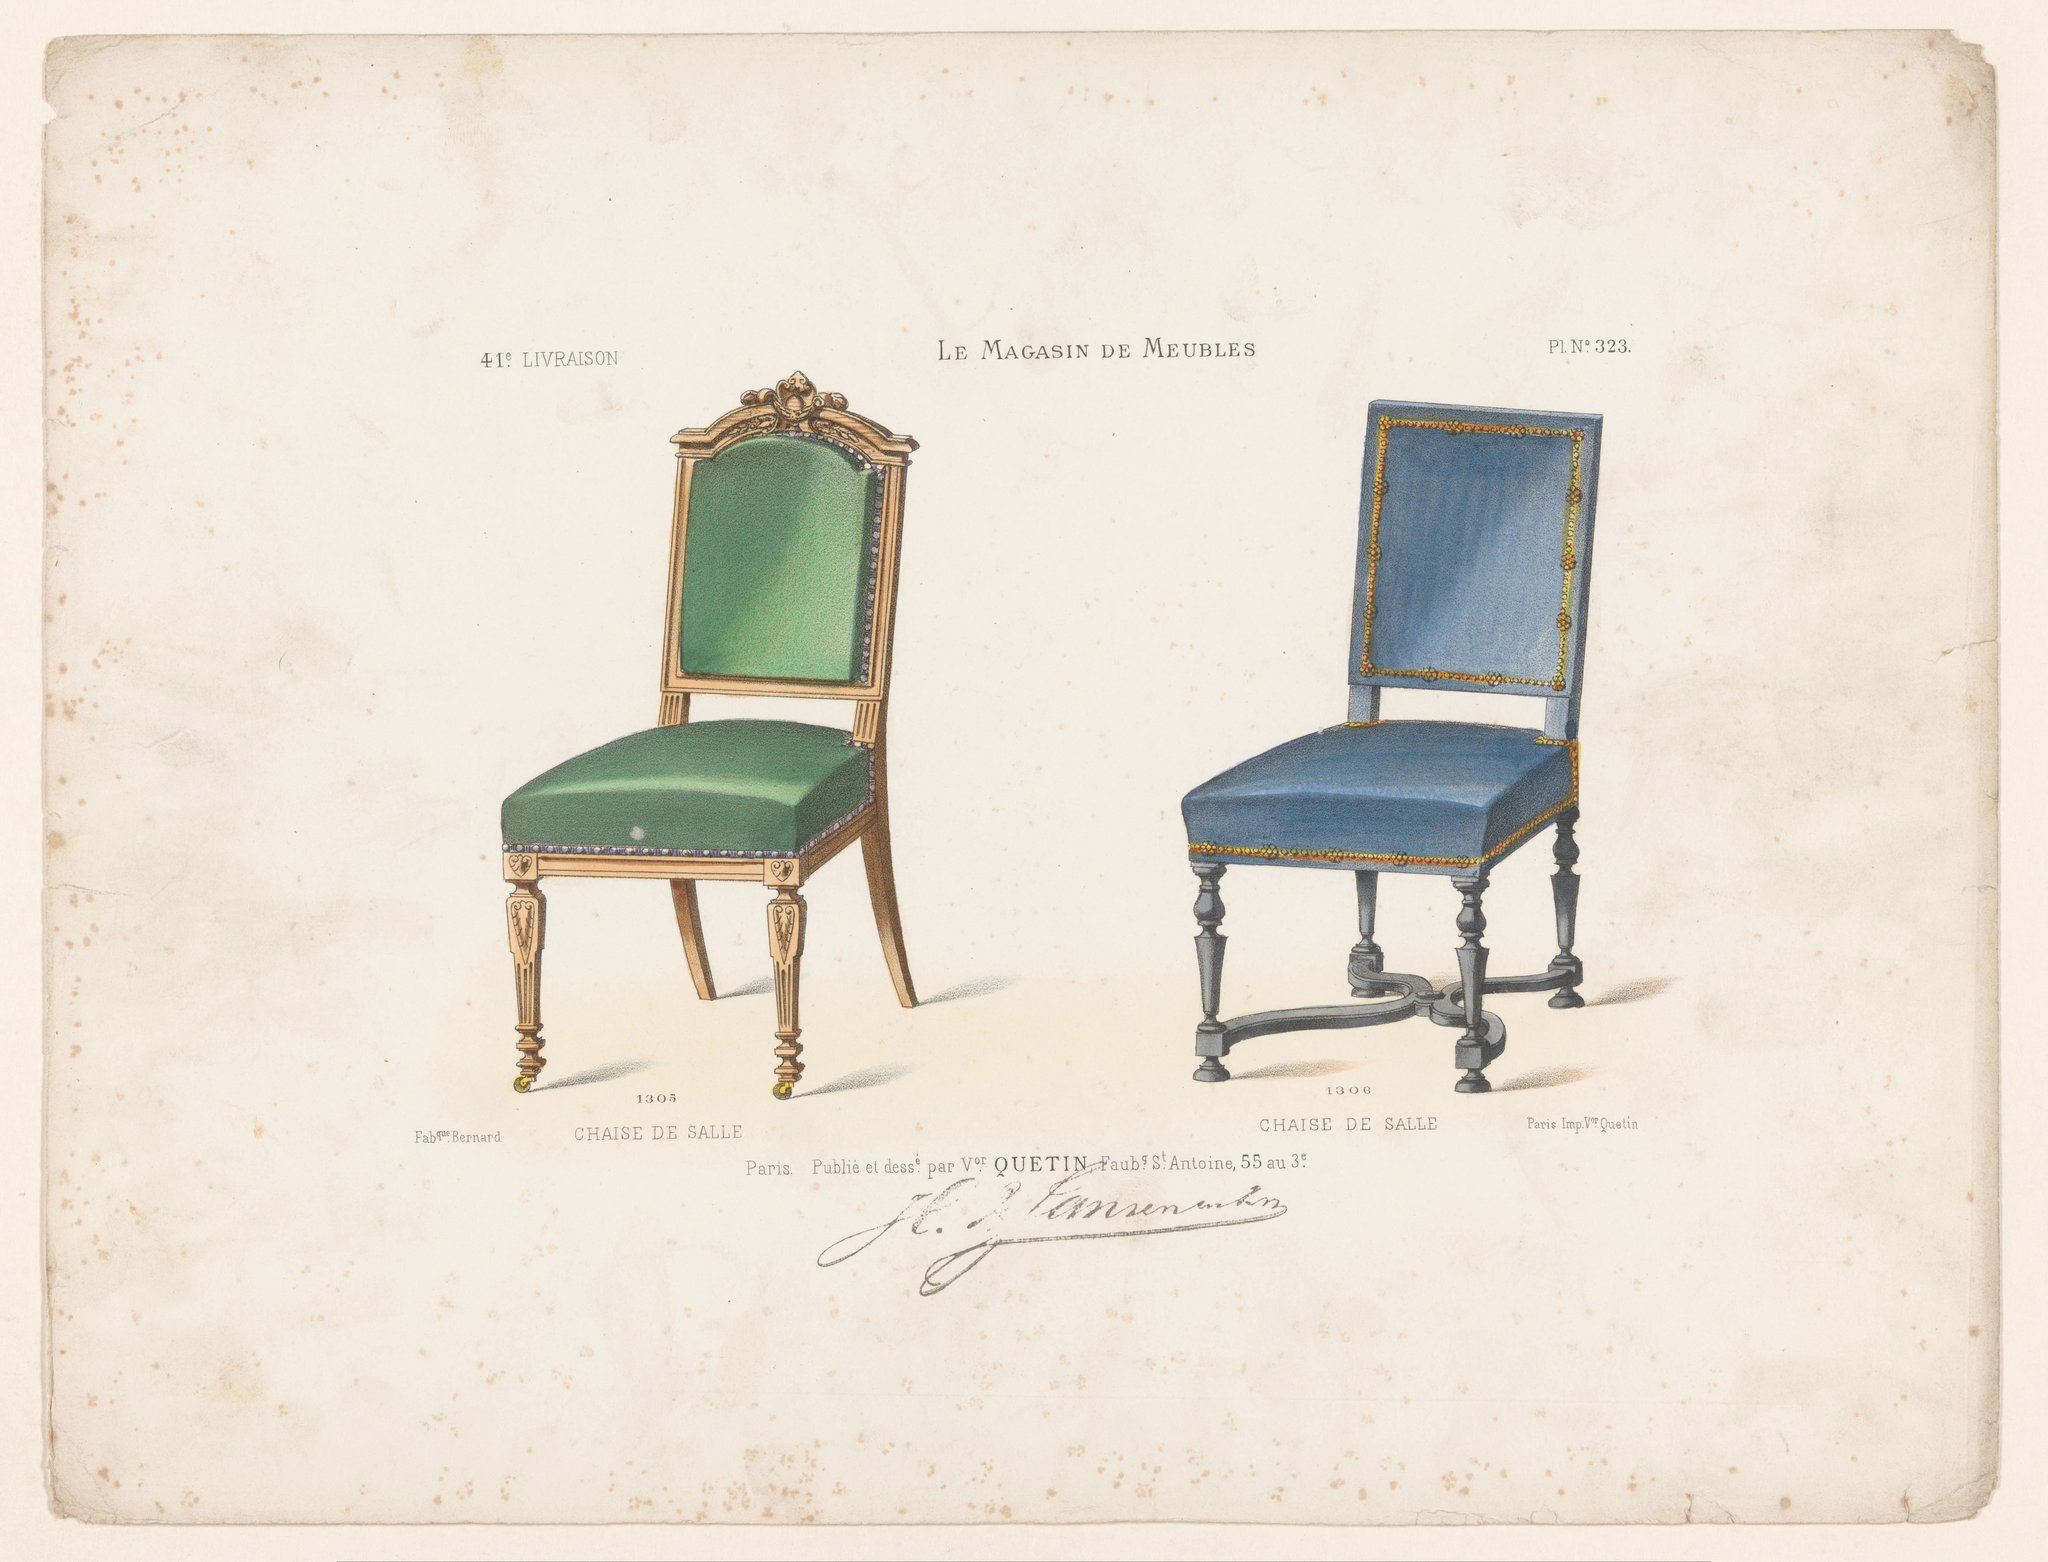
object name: print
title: Twee stoelen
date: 1832-1877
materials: paper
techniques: hand coloring, lithograph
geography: paris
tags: seating furniture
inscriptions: stamp: ‘H.F. Jansen en Zn’